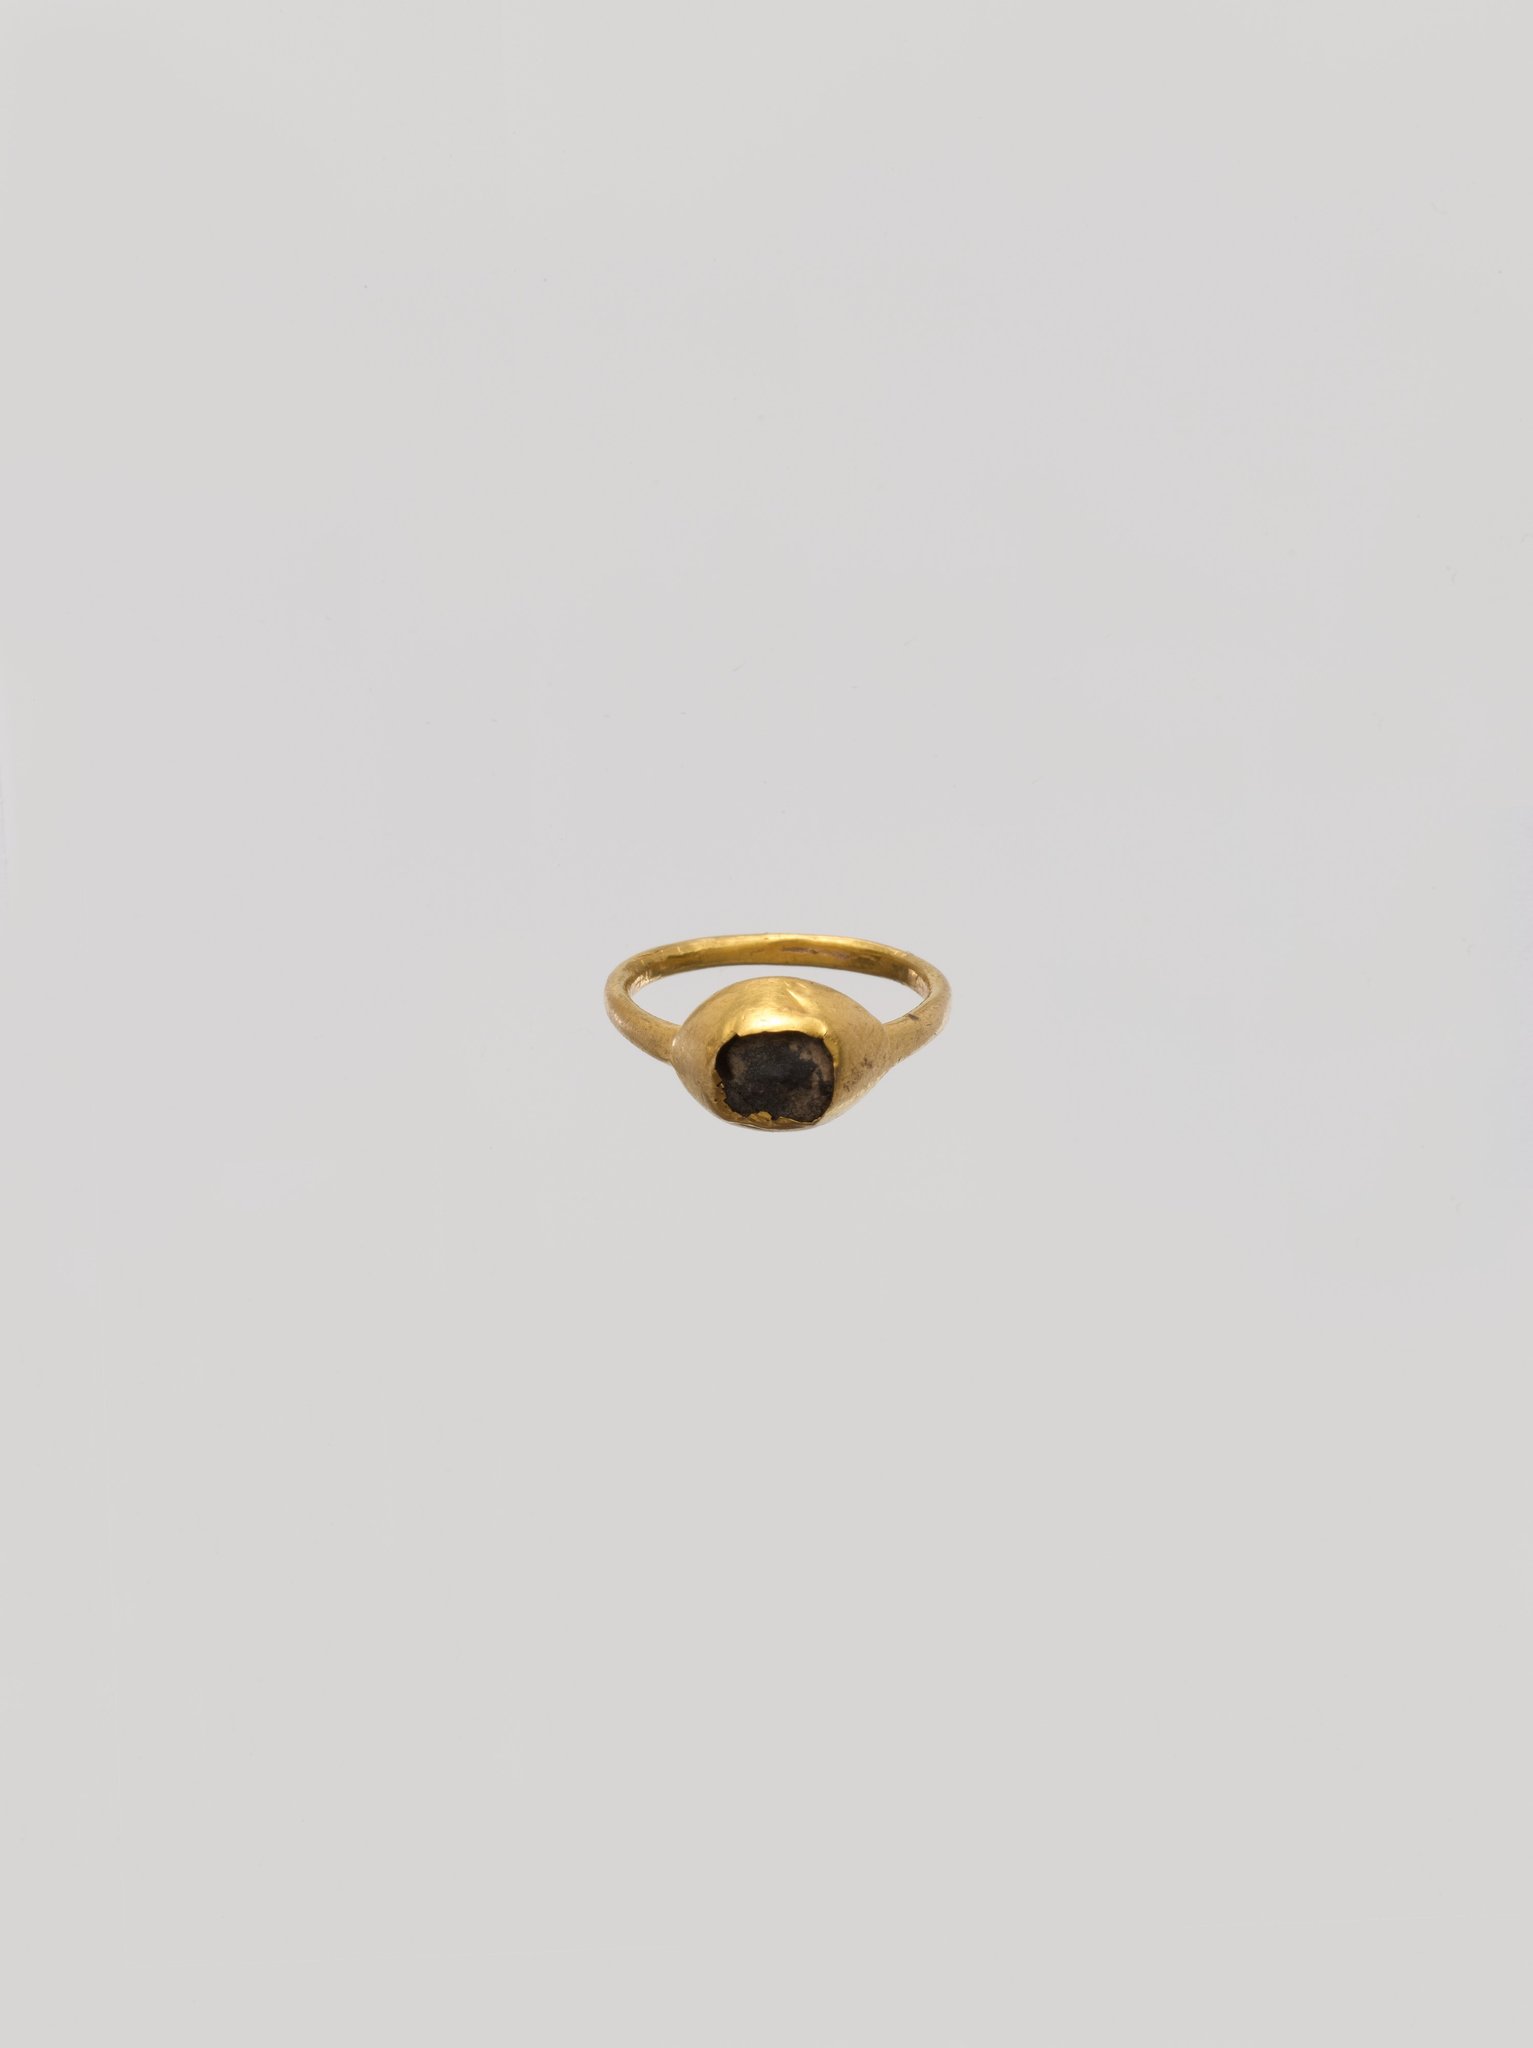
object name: ring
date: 801-1100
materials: gold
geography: iran